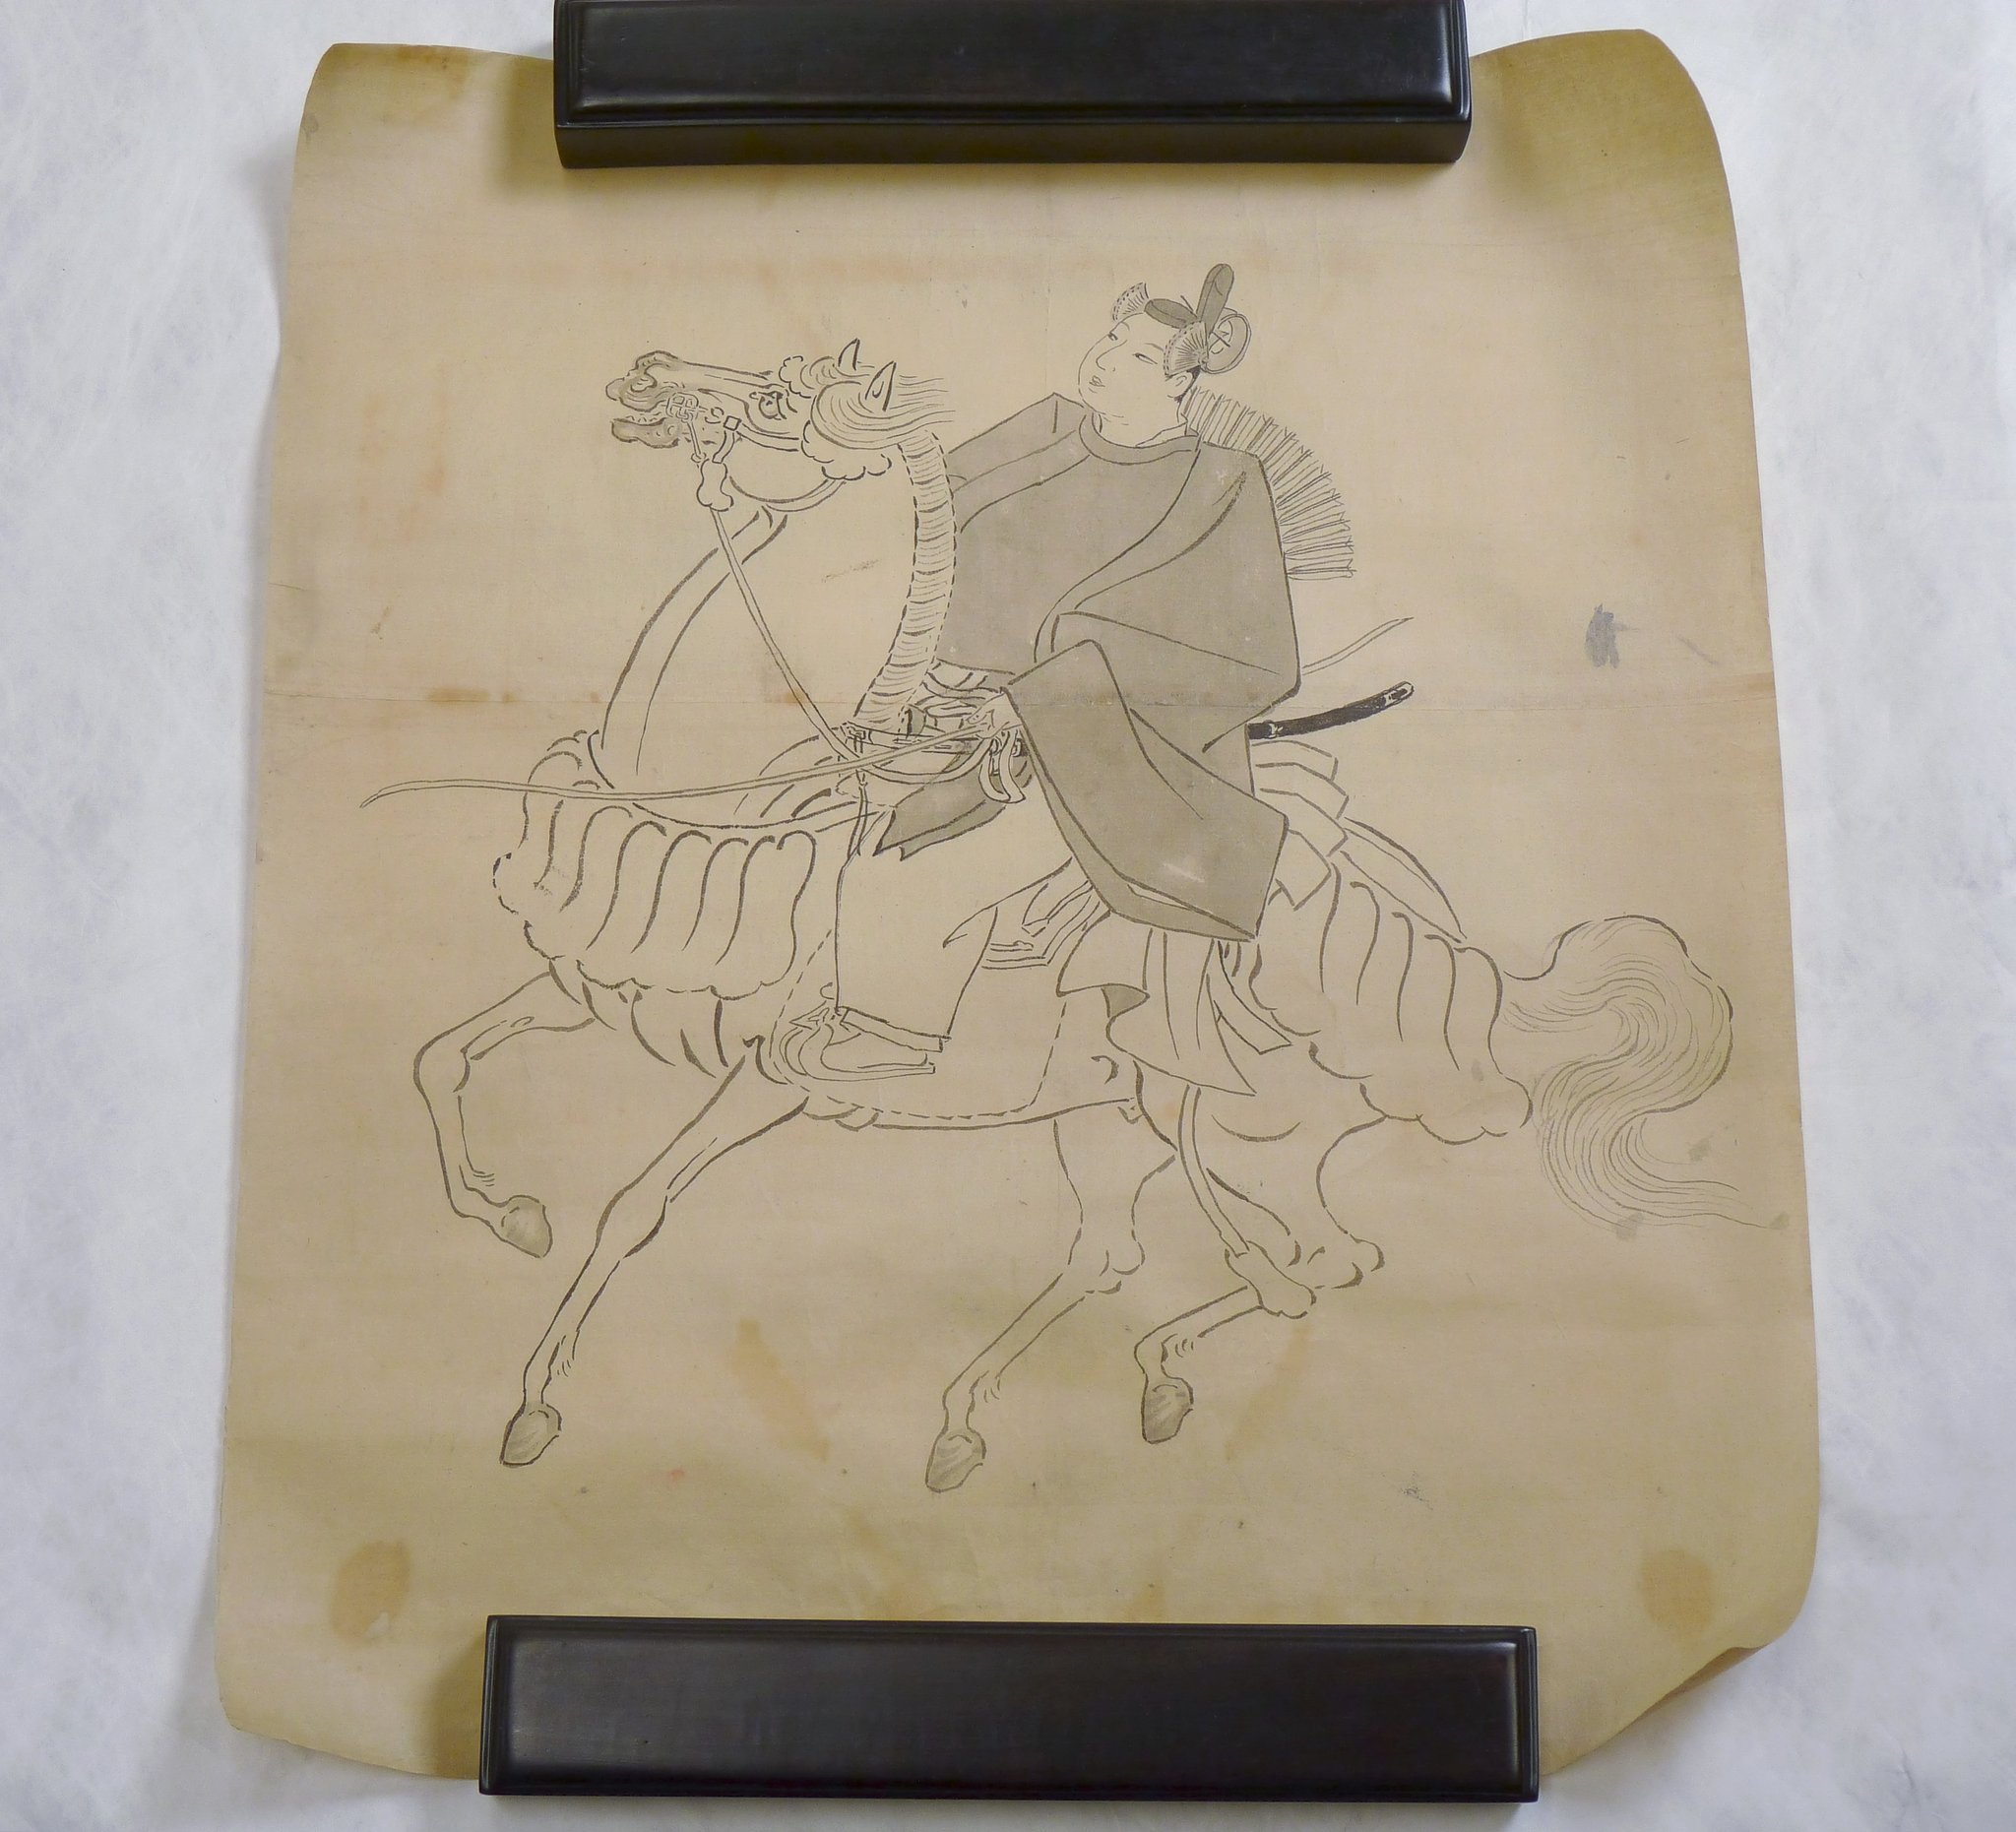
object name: drawing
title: Japanese Drawing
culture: japanese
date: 1801-1833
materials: paper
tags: horses